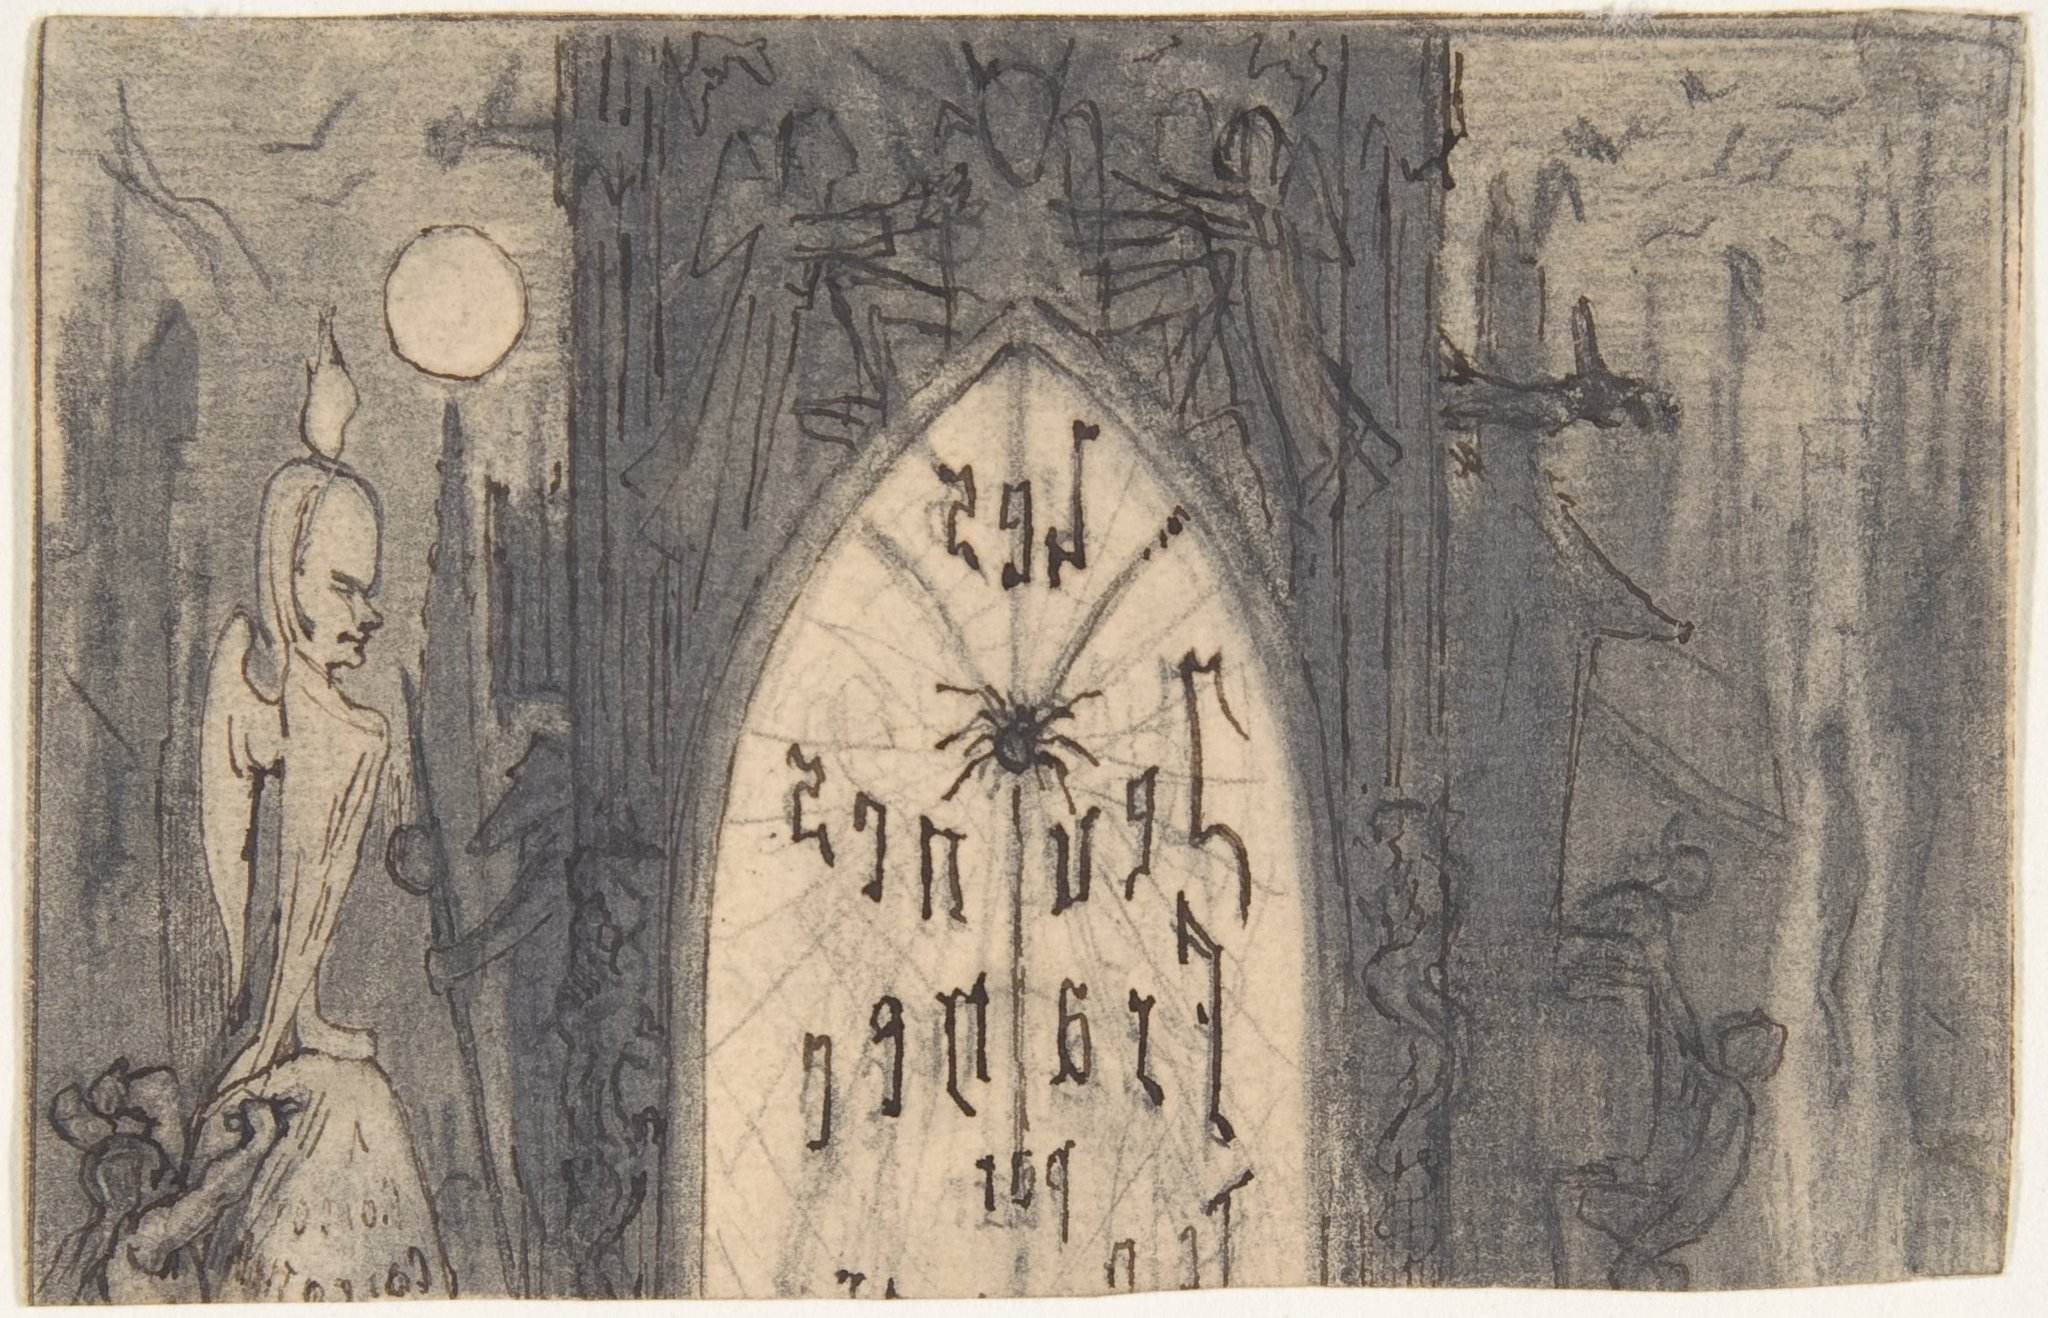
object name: drawing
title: Study for frontispiece to "Les Jeunes France" by Théophile Gautier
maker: félicien rops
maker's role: artist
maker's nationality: belgian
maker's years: 1833-1898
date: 1833-1898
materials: graphite, ink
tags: human figures,insects,moon